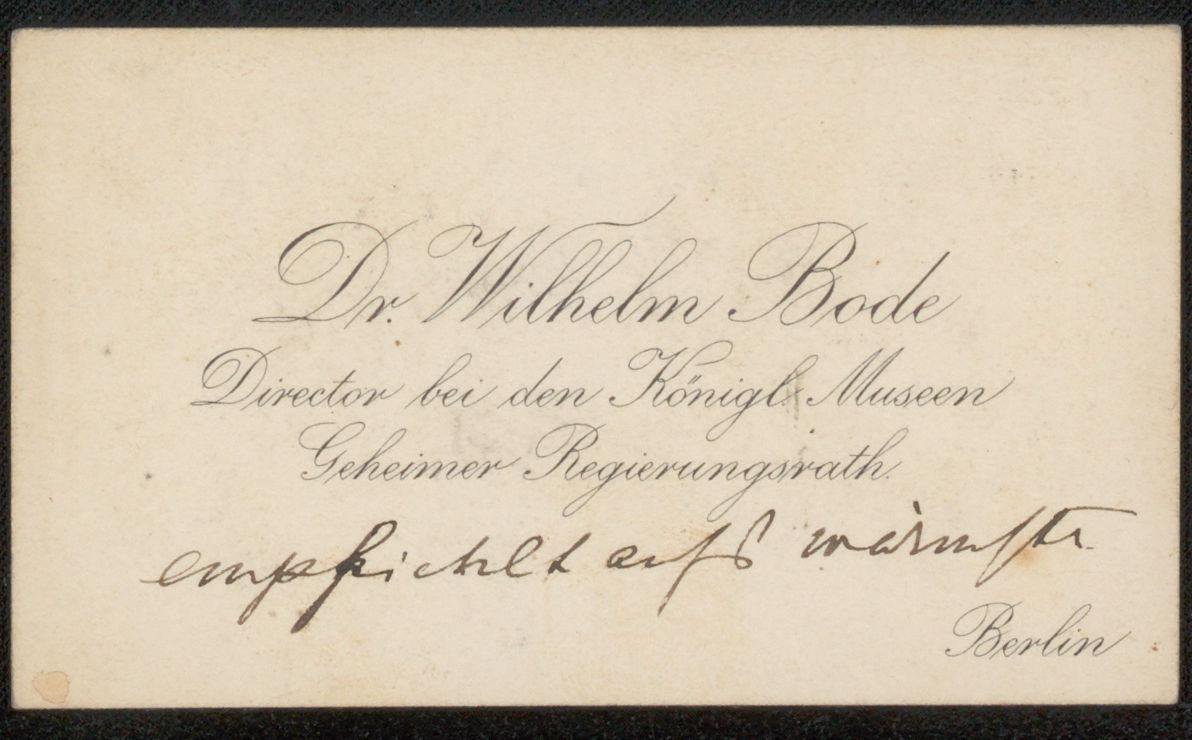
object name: visiting card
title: Visitekaartje aan Jan Veth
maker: wilhelm von bode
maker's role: conservator, kunsthistoricus, museumdirecteur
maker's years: 1845-1929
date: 1874-1925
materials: cardboard, ink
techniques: pen, printing, writing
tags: dordrecht, painter, print maker, draughtsman, designer, jan veth, painting (including book-illumination, miniature-painting), printed matter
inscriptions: collector's mark: ‘RPK’